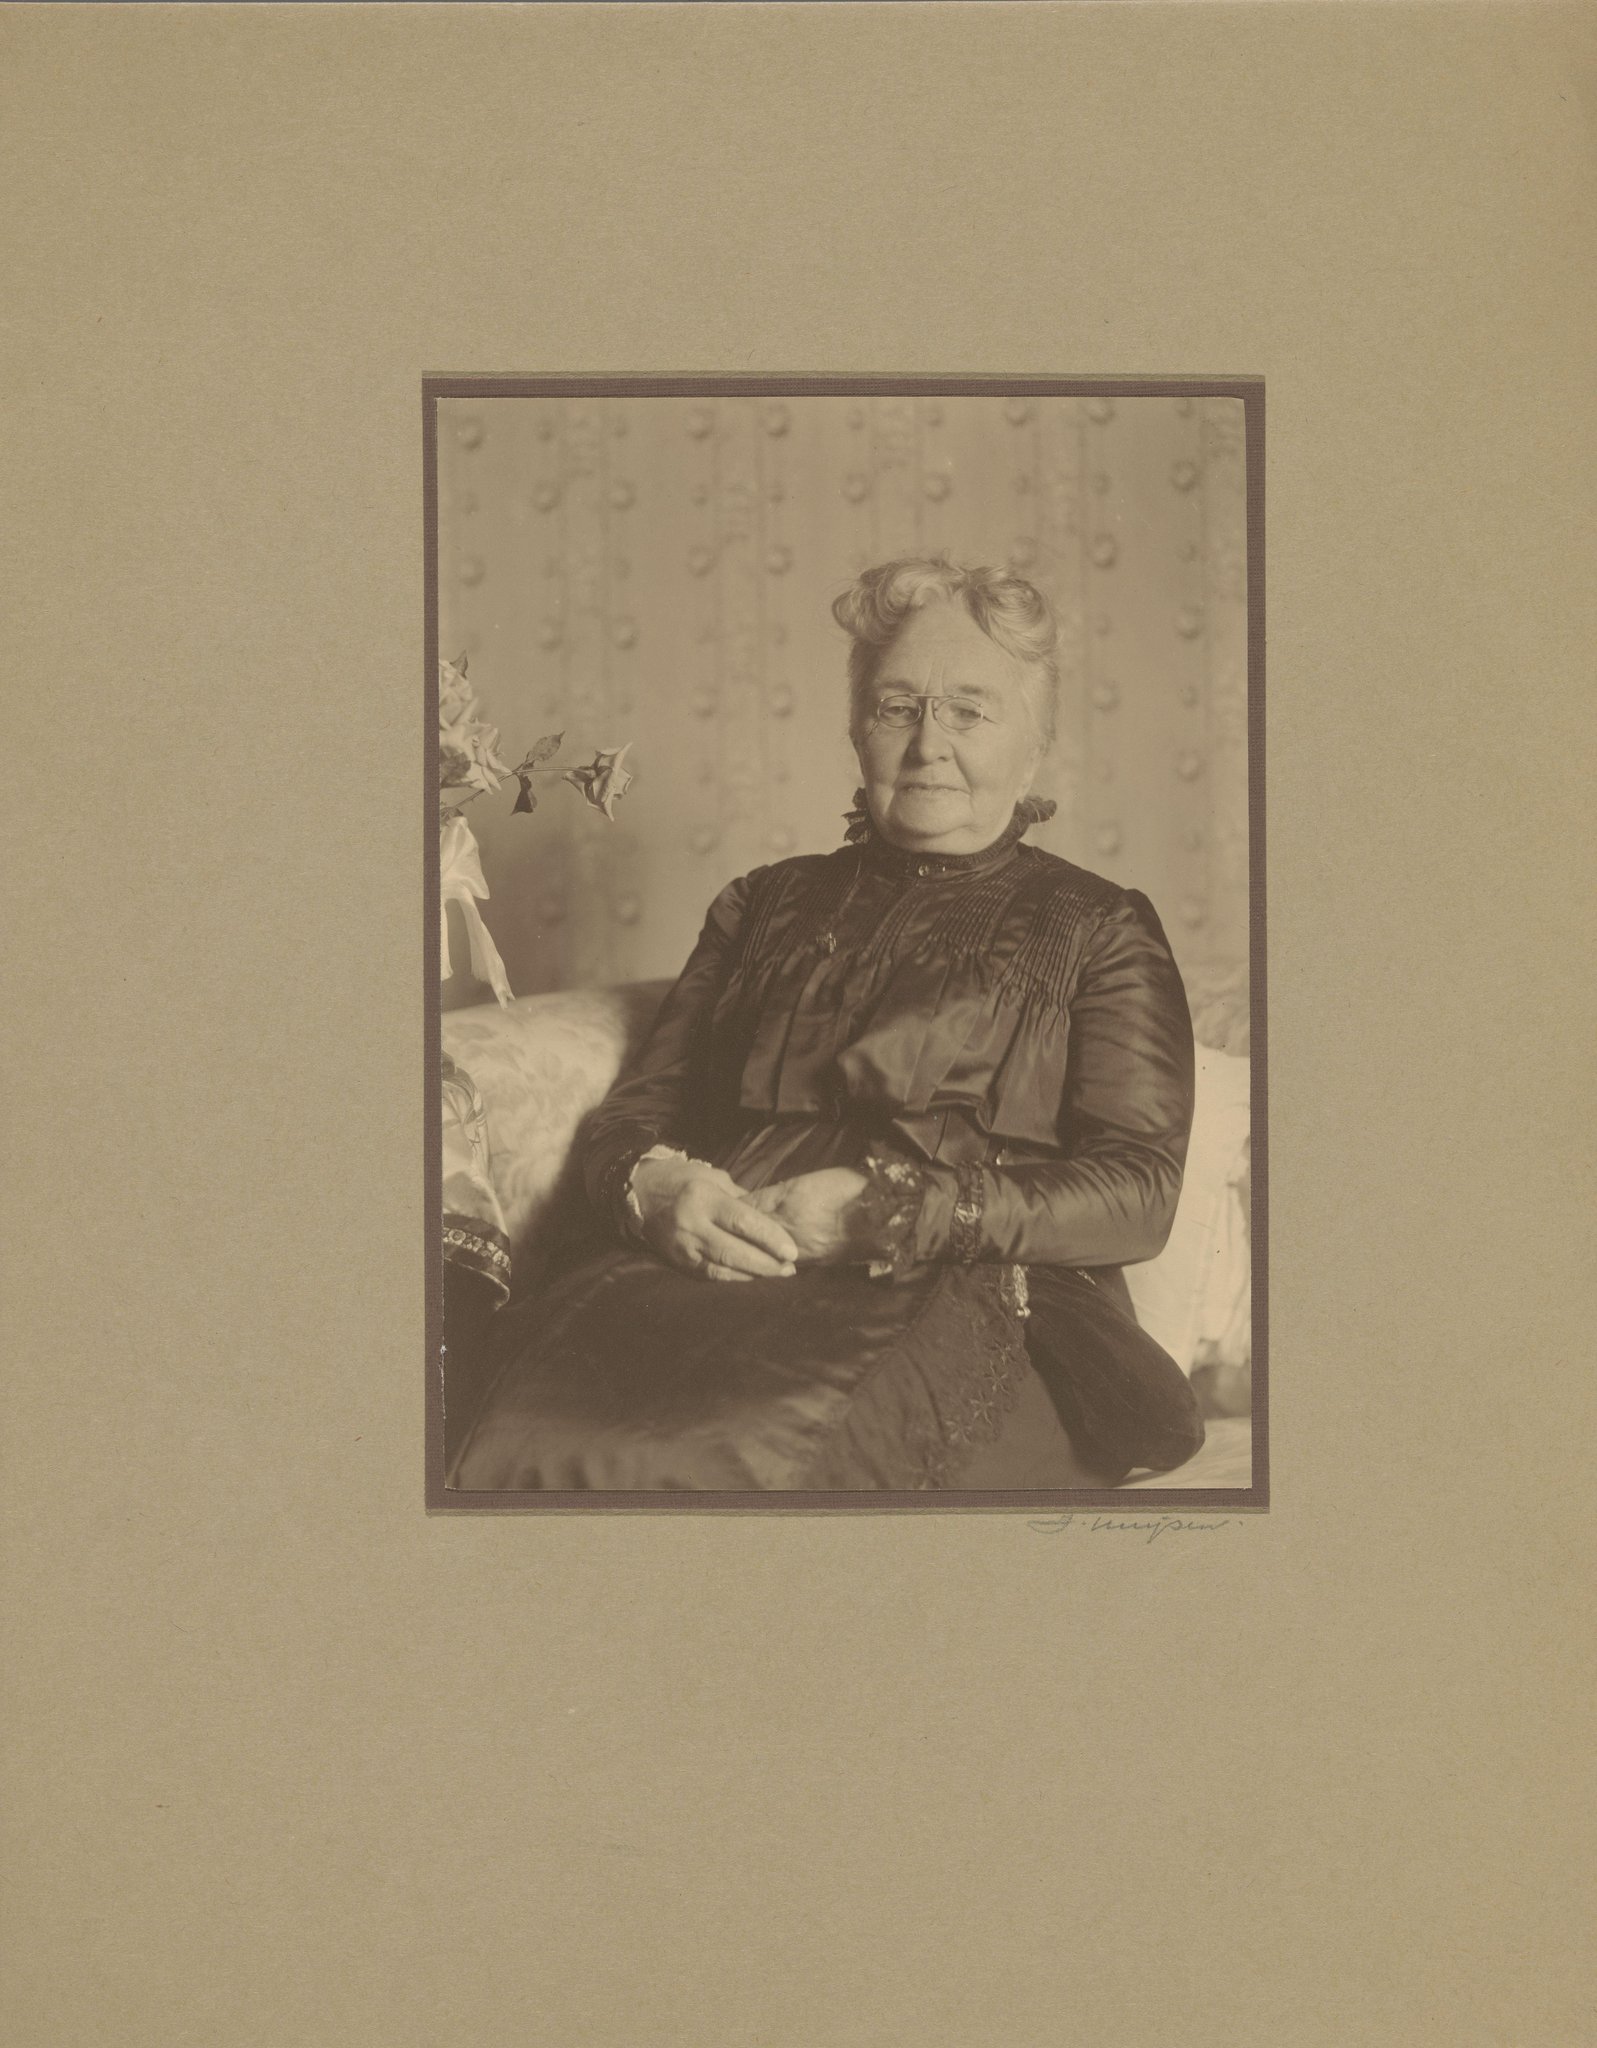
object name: photograph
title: Portret van een onbekende vrouw, vermoedelijk gerelateerd aan de familie Marmelstein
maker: j. kuipers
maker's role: fotograaf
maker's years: 1845-1925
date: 1900-1940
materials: paper, cardboard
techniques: gelatin silver print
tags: adult woman, child, historical persons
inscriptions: signature: ‘J. Kuipers’